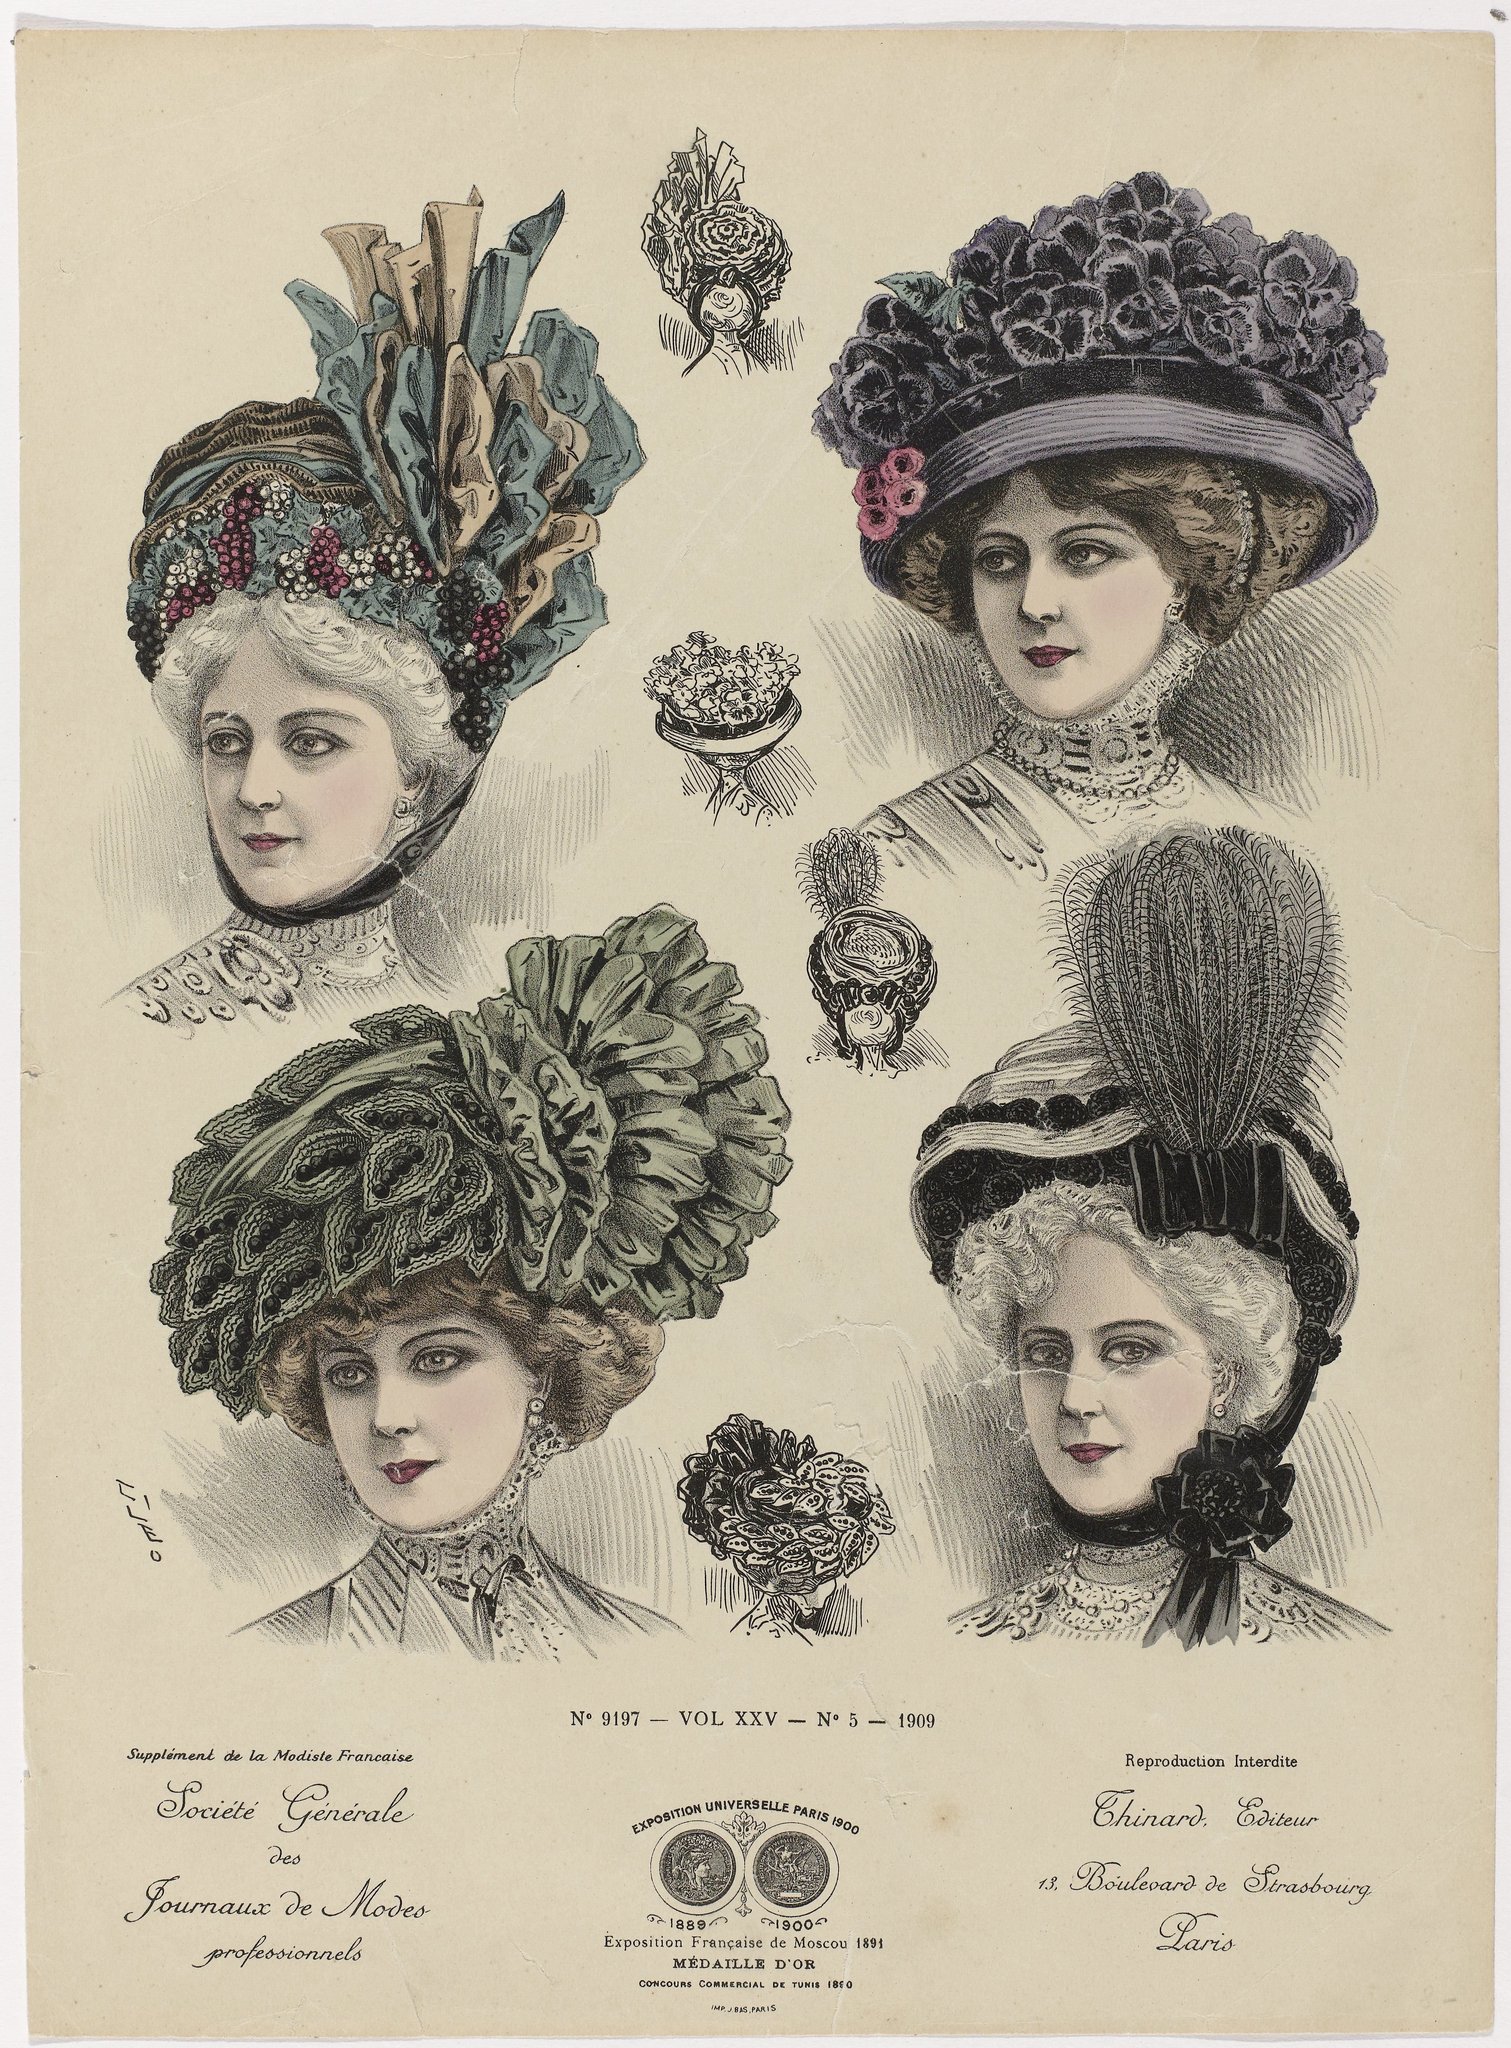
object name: fashion print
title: Société Générale des Journaux de Modes professionnels 1909, No. 9197, Vol. XXV, No. 5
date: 1909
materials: paper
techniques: printing, photochemical processes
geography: paris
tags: flowers, flowers: violet, border, ribbon, braid (+ women's clothes), fashion plates, head-gear: hat (+ women's clothes), bunch of grapes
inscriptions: address: ‘Reproduction Interdite / Thinard Editeur / 13, Boulevard de Strassbourg / Paris’, inscription: ‘No. 9197 - VOL XXV - No 5 - 1909 / EXPOSITION UNIVERSELLE PARIS 1900 / 1889 1900 / Exposition Française de Moscou 1891 / MËDAILLE D'OR / CONCOURS COMMERCIAL DE TUNIS 1890’, title: ‘Supplément de la Modiste Francaise / Société Générale des Journaux de Modes professionnels’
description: Vier vrouwenhoofden met verschillende hoeden, waarnaast een kleine lijntekening van de achterzijde. Linksboven: hoed met band onder de kin, versierd met druiventrossen. Rechtsboven: paarse ronde hoed versierd met viooltjes. Linksonder: groene hoed vesrierd met bladeren (?). Rechtsonder: hoed met striklinten, versierd met zwarte strik en aigrette. Prent uit het modetijdschrift Société des journaux de modes réunis (1847 -...?).